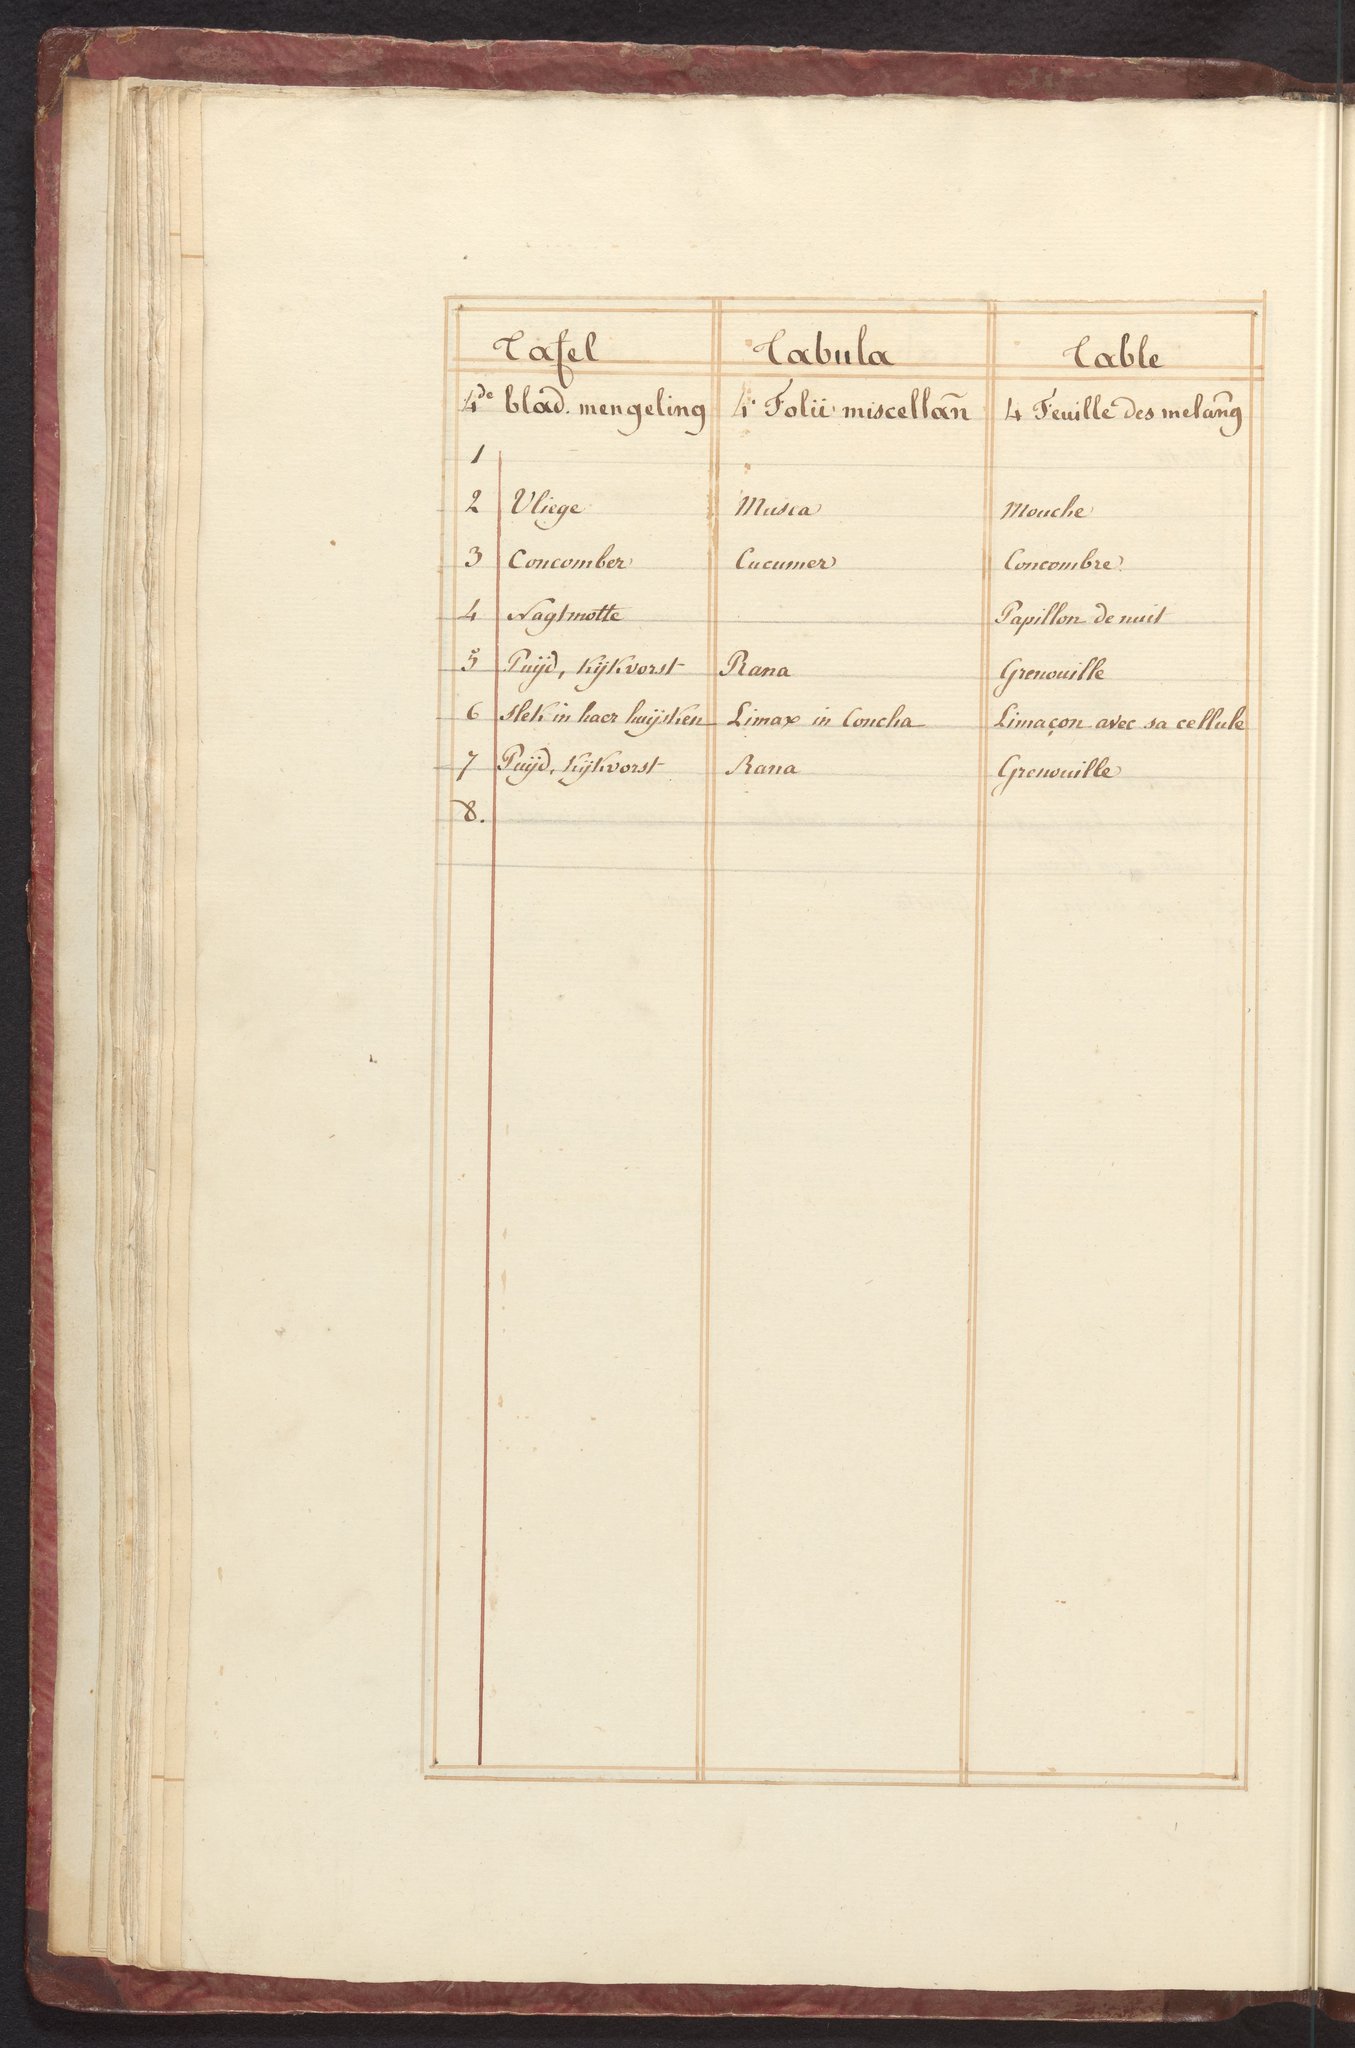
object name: manuscript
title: Lijst van dieren en planten in het vierde ensemble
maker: joseph van huerne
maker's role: kunstliefhebber, mecenas, verzamelaar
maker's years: 1752-1844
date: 1809-1814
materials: ink, paper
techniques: handwriting, pen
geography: bruges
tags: handwriting, written text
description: Schema met een lijst in drie kolommen van de dieren en planten afgebeeld in het vierde ensemble, nummers 1-8. Onderdeel van het zevende album met tekeningen van reptielen, amfibieën en natuurhistorische ensembles. Het zevende van twaalf albums met aquarellen van dieren, vogels en planten bekend rond 1600, gemaakt in opdracht van keizer Rudolf II. Met toelichting in Nederlands, Latijn en Frans.